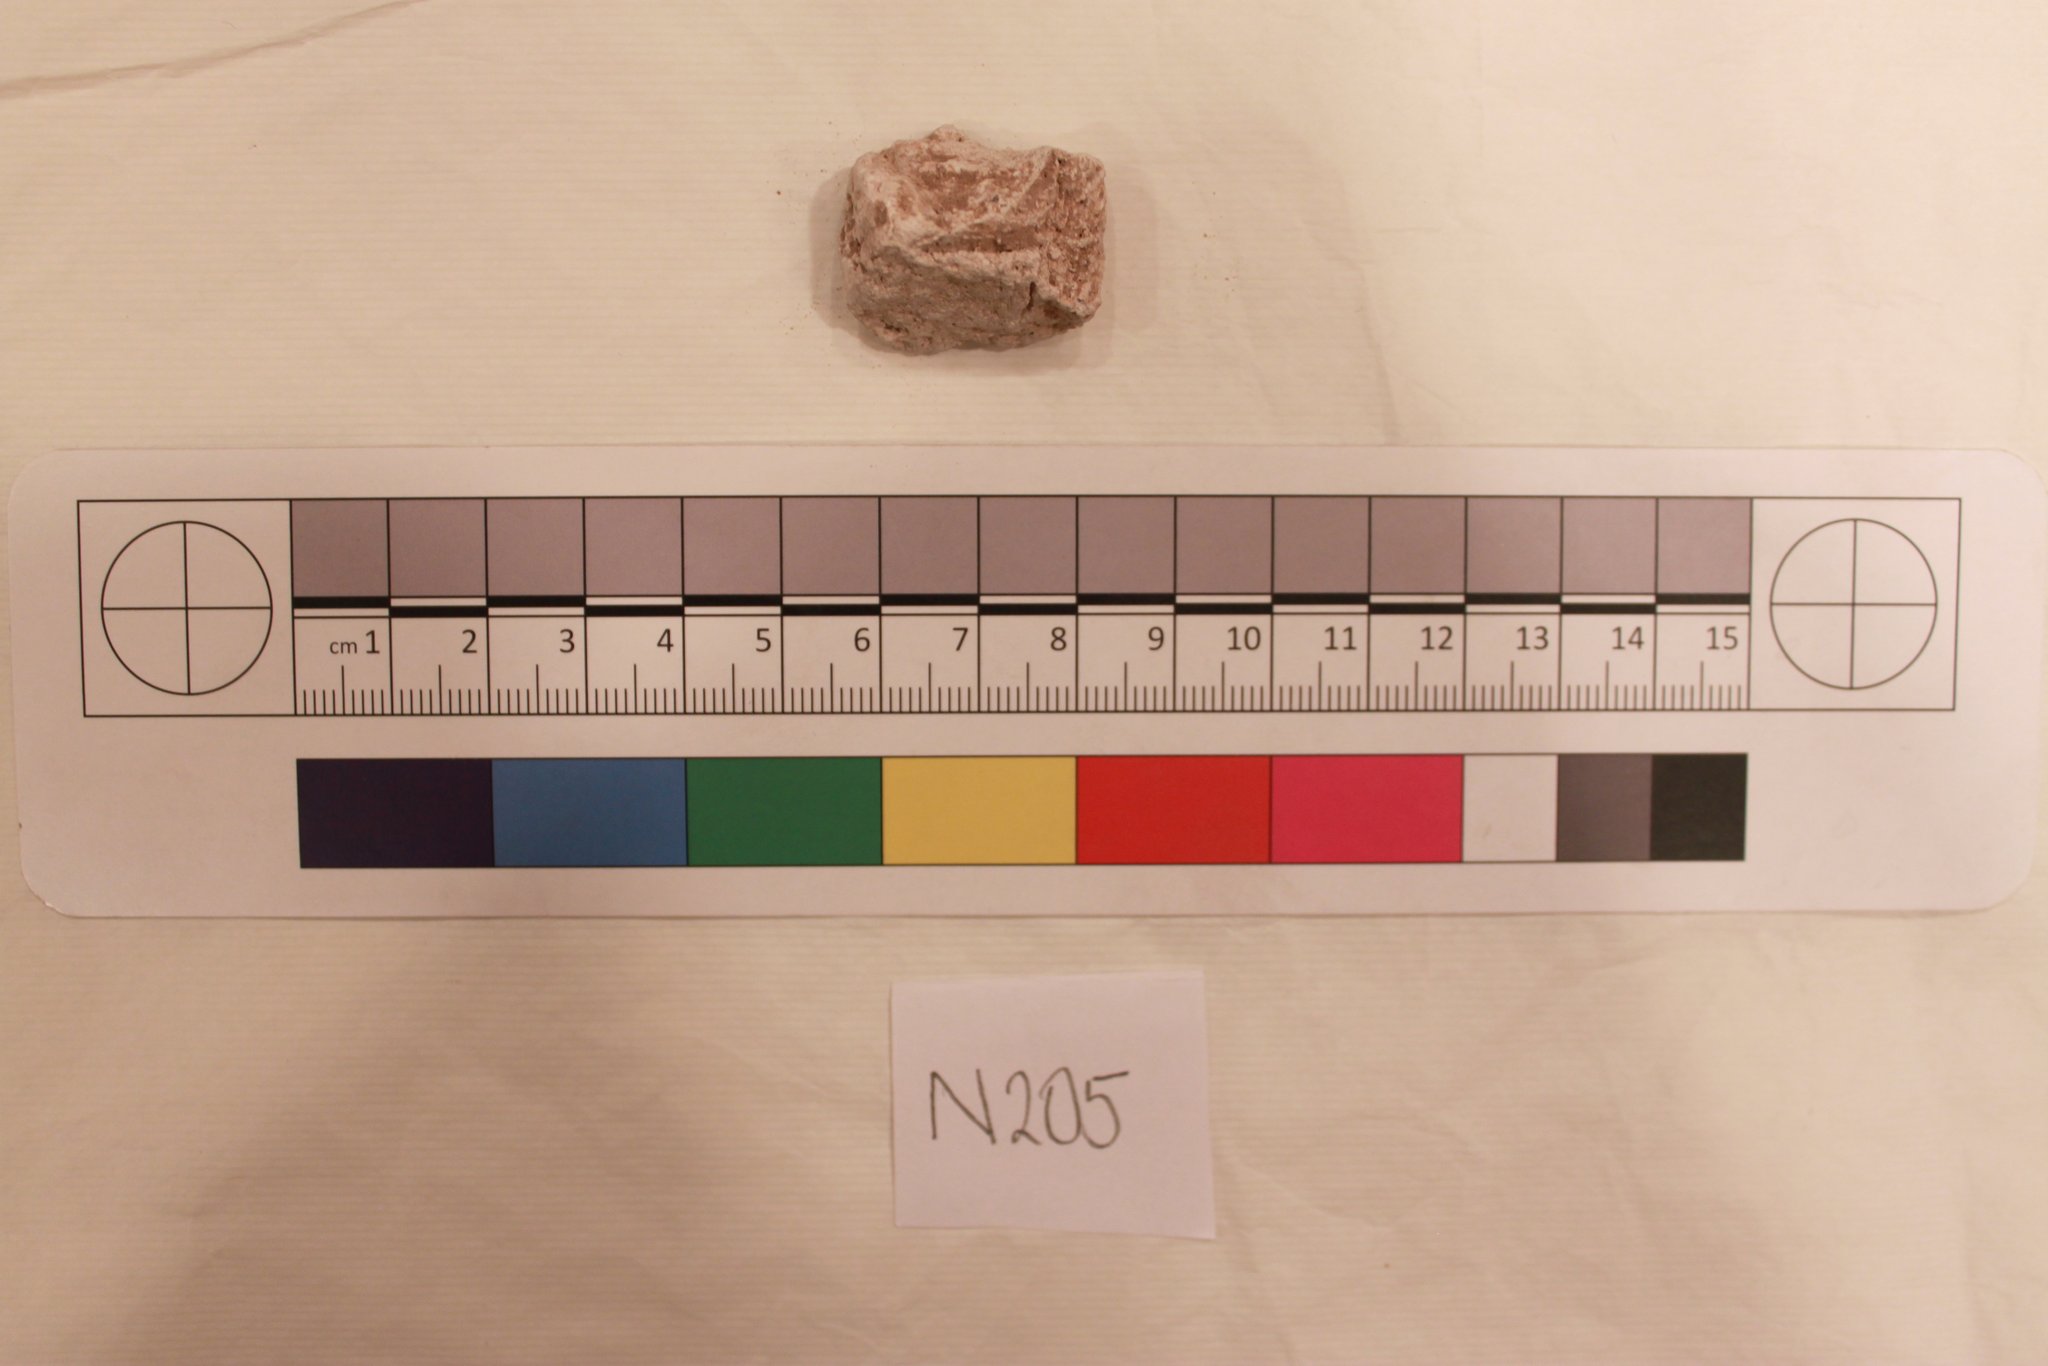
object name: fragment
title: Stucco Fragment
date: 701-1200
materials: plaster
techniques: carving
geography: iran